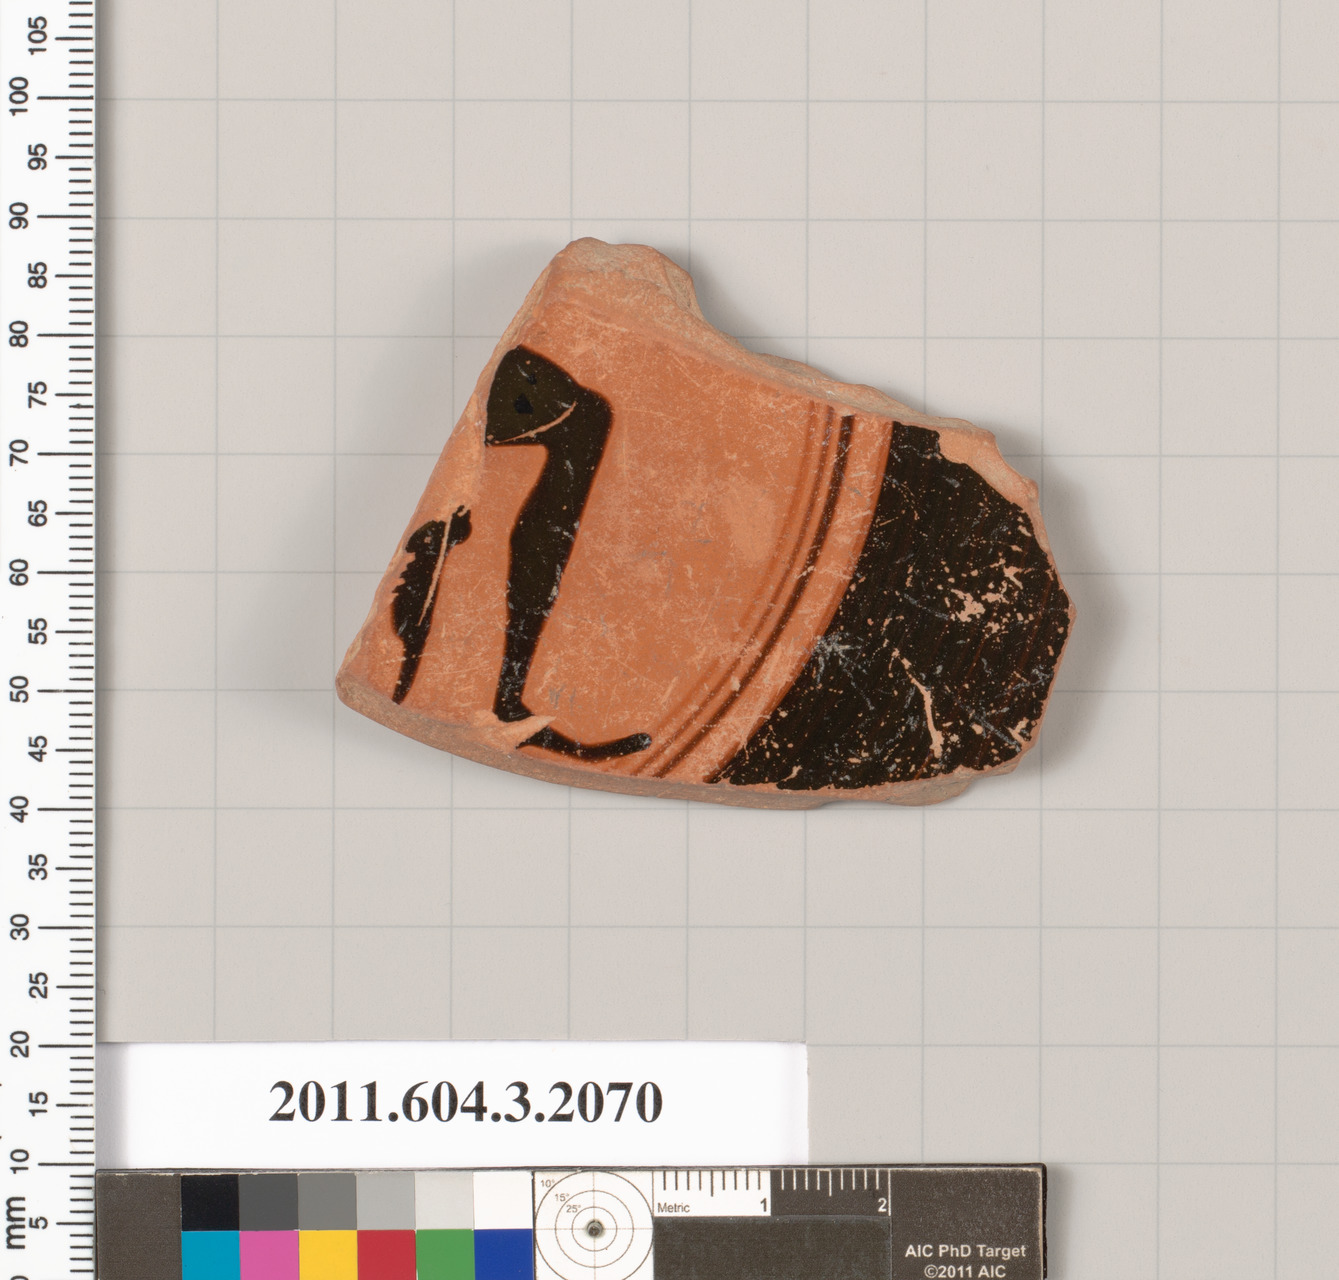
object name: kylix fragment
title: Terracotta fragment of a kylix (drinking cup)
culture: greek, attic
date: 500-468 BCE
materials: terracotta